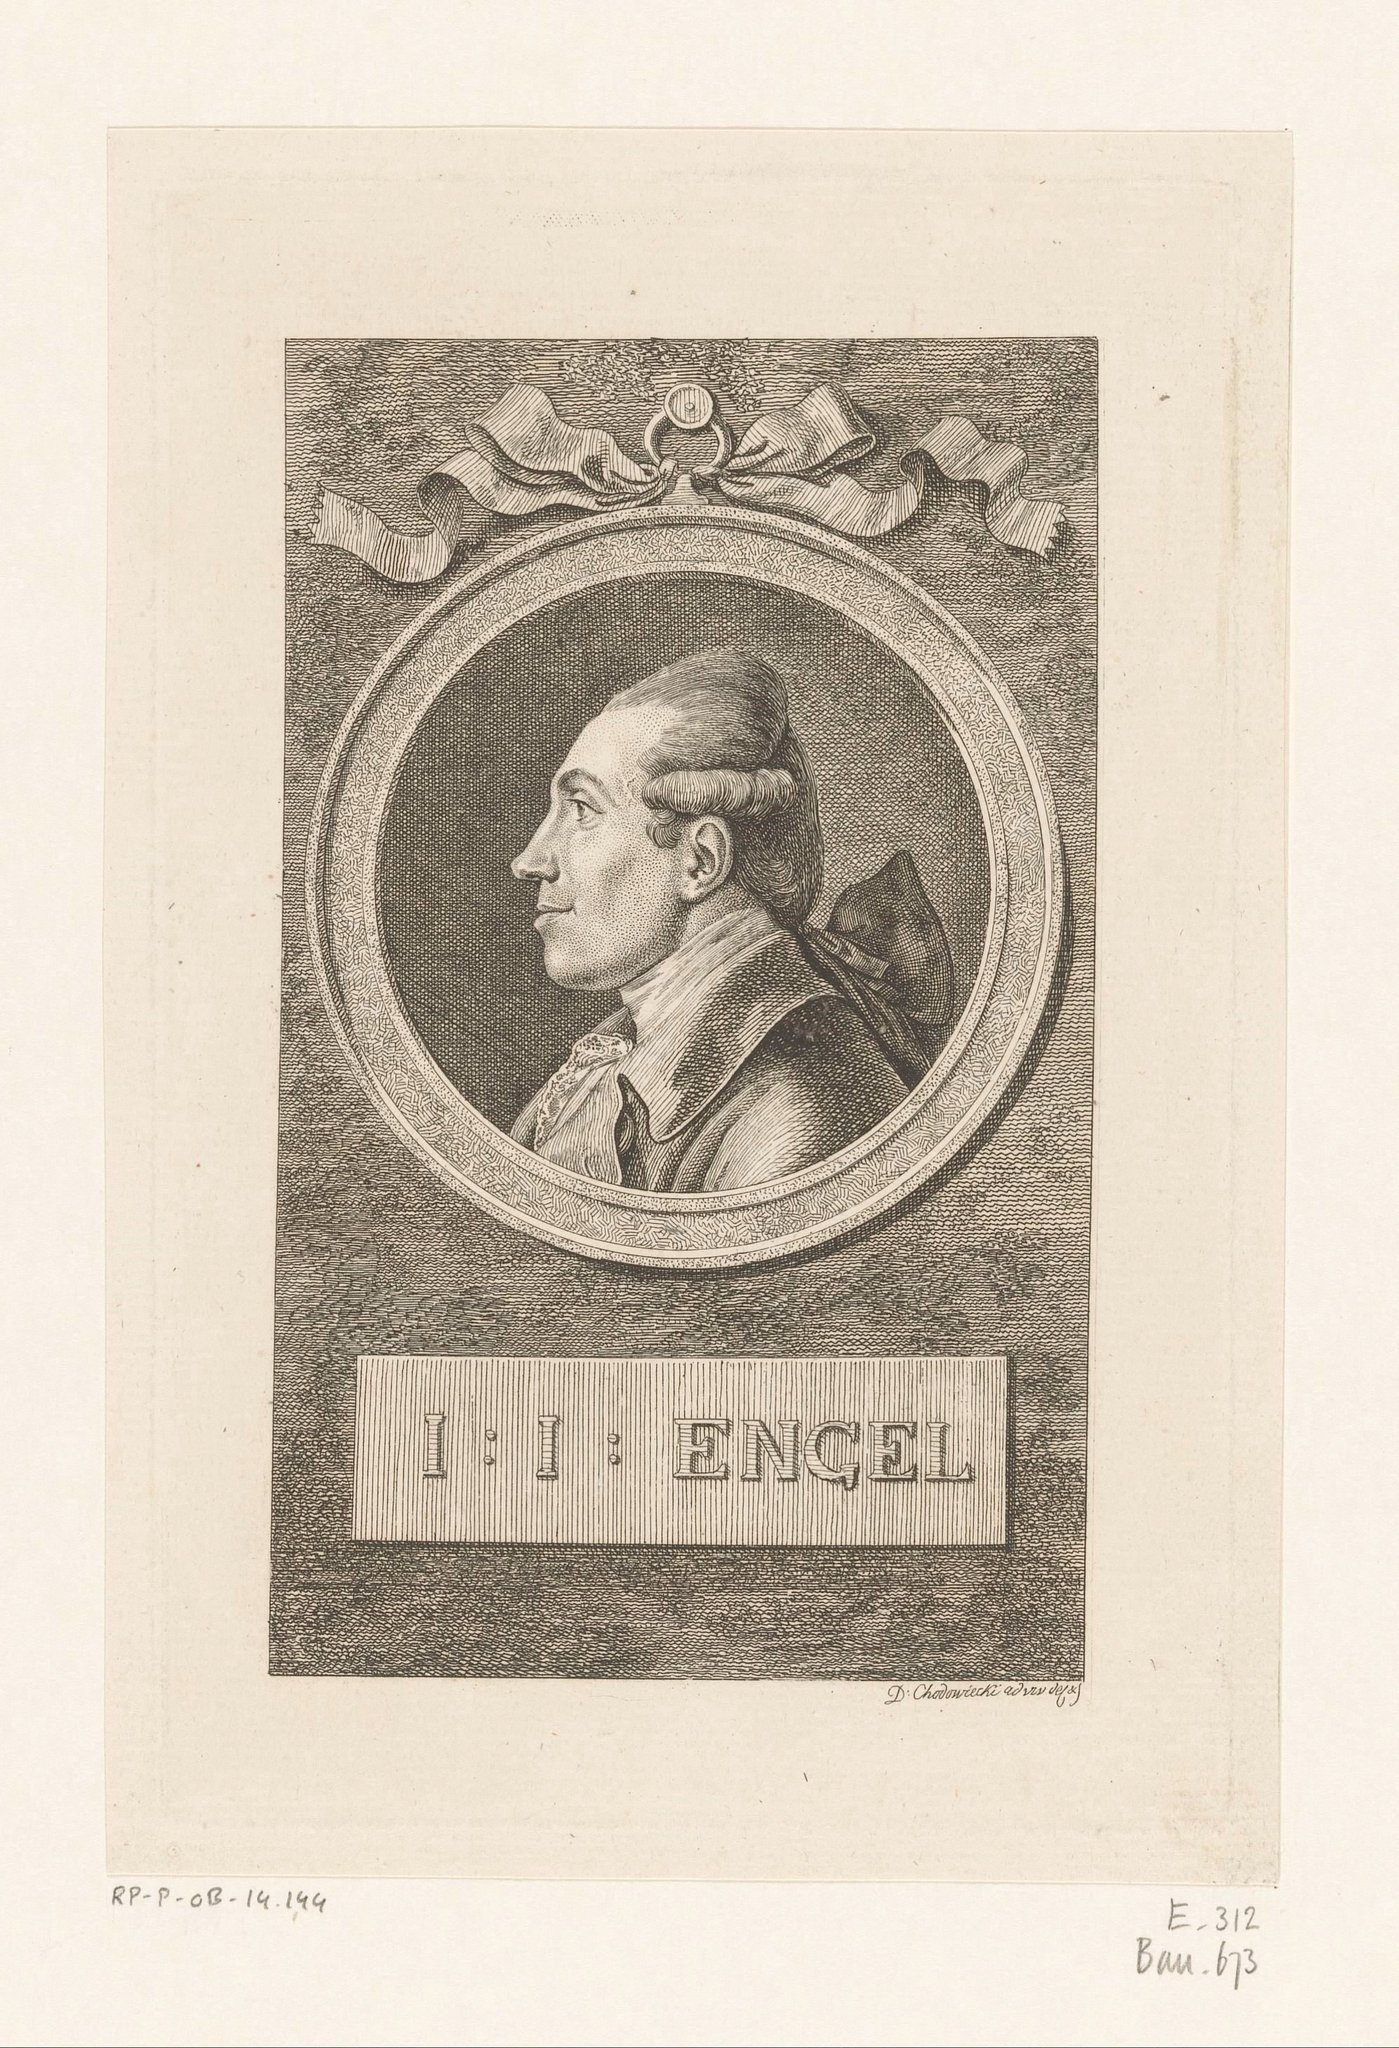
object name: print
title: Portret van Johann Jacob Engel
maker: daniel nikolaus chodowiecki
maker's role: draughtsman, print maker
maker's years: 1726-1801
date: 1779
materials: paper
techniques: etching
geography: berlin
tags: historical persons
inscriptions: collector's mark: Lugt 2228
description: Prent ook gebruikt in: Allgemeine deutsche Bibliothek. Berlijn en Stettin: Friedrich Nicolai, 1779, dl. 39, eerste stuk.